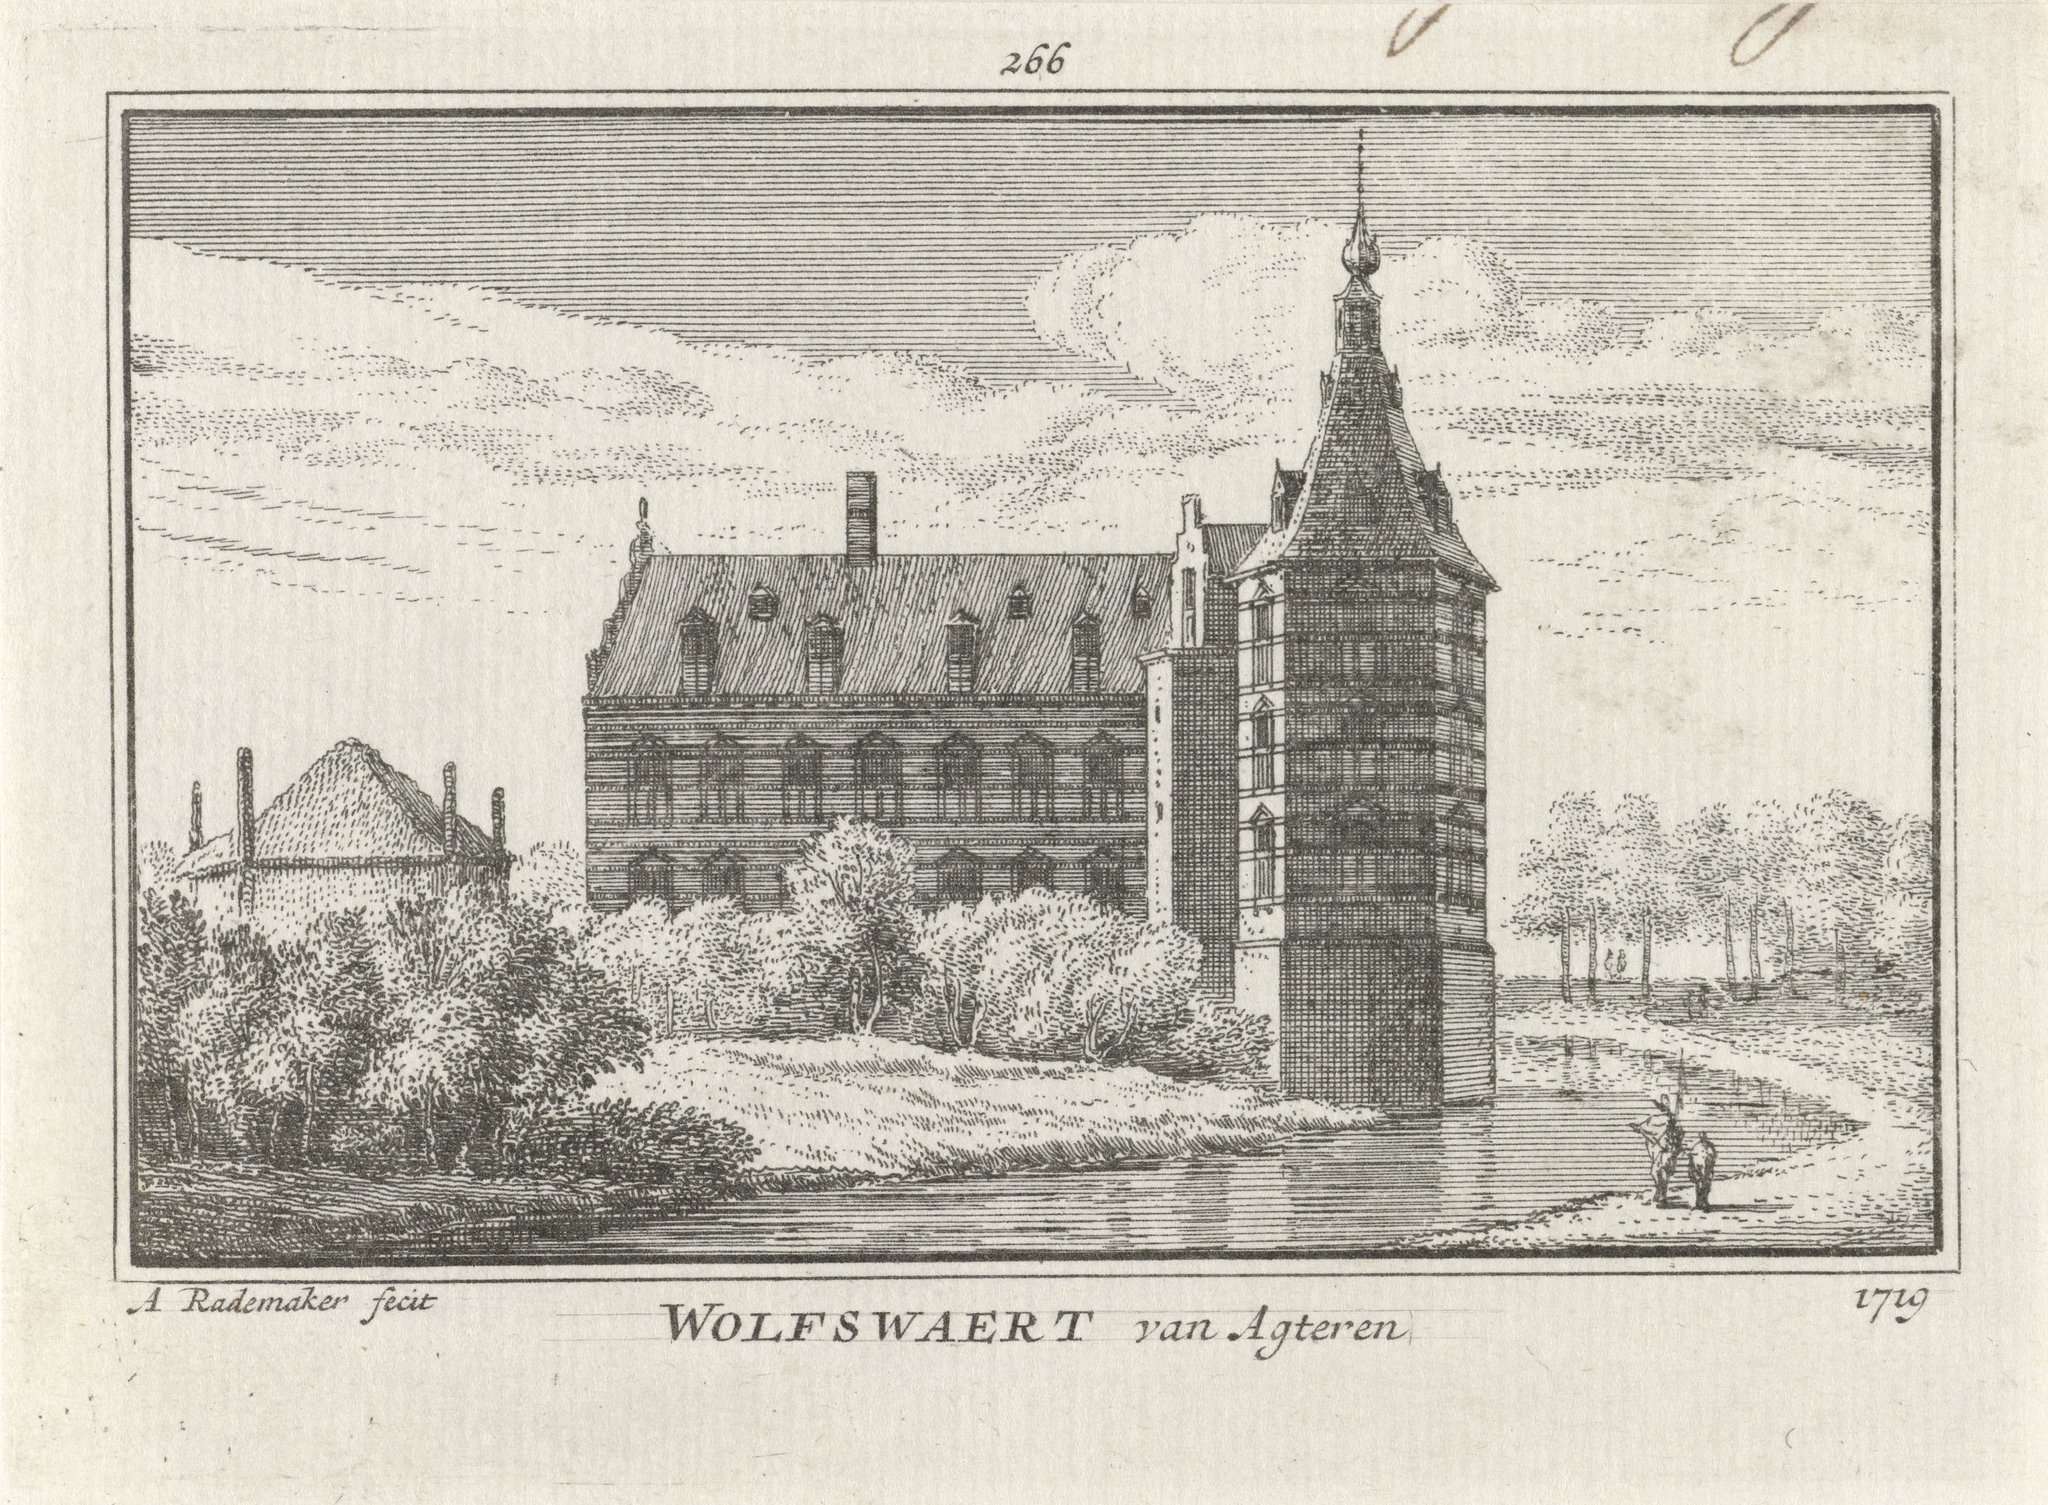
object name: book illustration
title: Wolswaert van Agteren 1719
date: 1727-1733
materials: paper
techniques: etching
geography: amsterdam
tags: castle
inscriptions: collector's mark: Lugt 2228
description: Illustratie uit: Abraham Rademaker, Matthaeus Brouërius van Niedek, Isaac Le Long, Kabinet van Nederlandsche en Kleefsche outheden en (...) voorname stads- en landgebouwen, Willem Barents en Antoni Schoonenburg: Amsterdam, 1727-1733, ill. nr. 266.